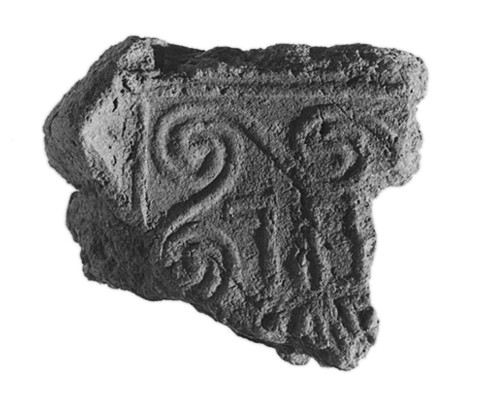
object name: sealing fragment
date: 2030-1640 BCE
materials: clay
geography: egypt